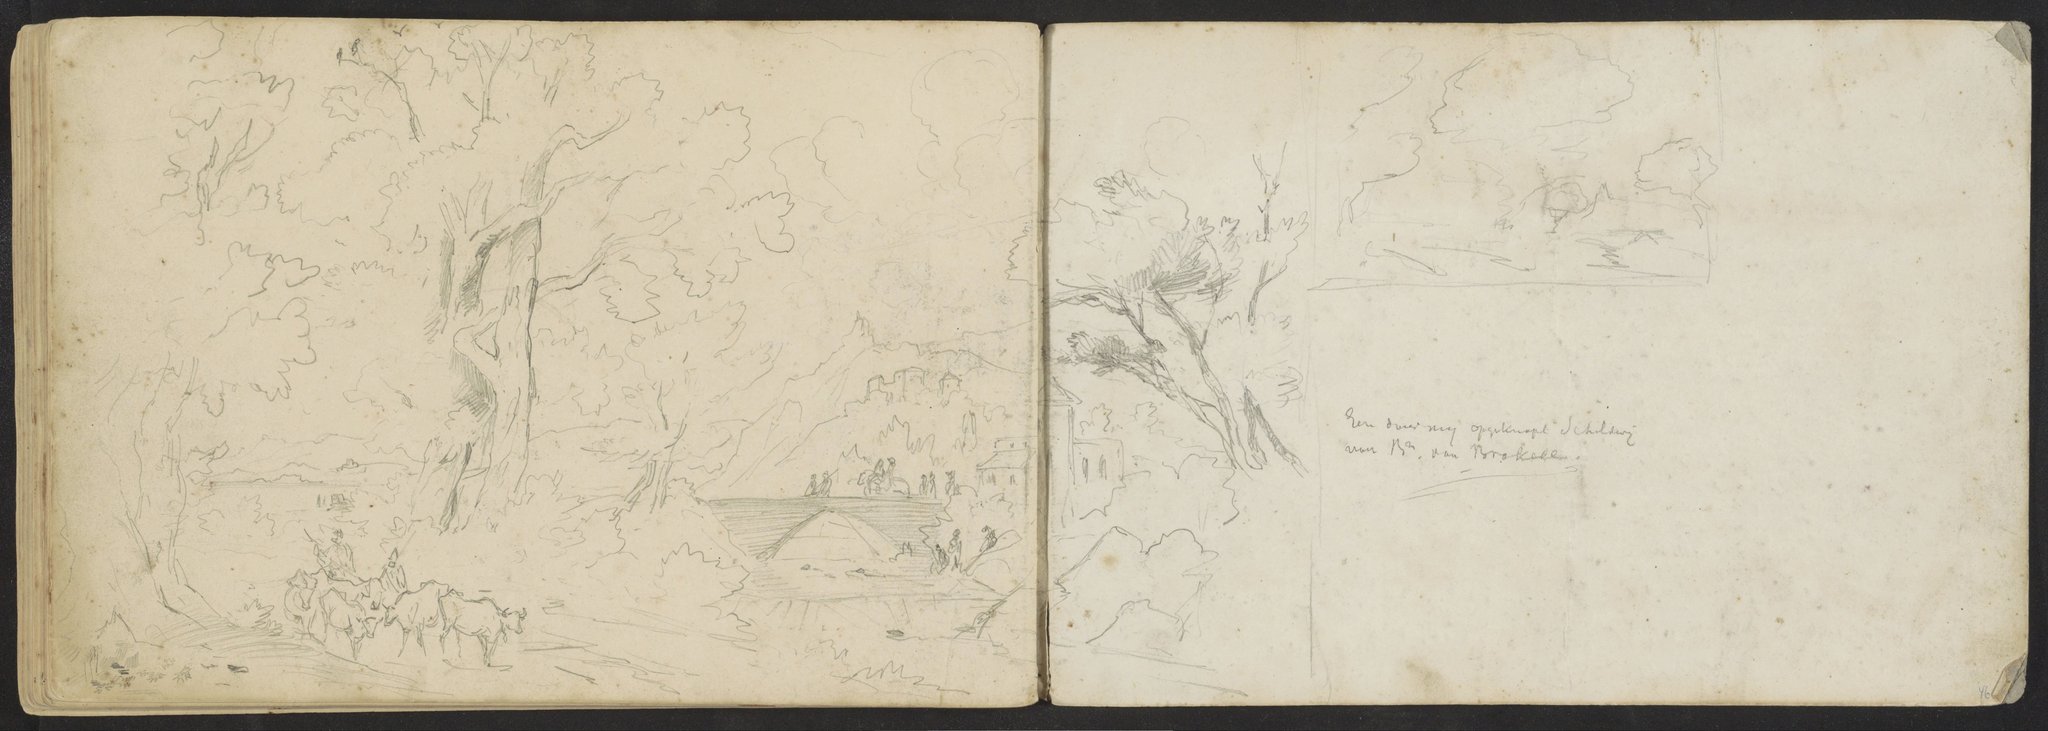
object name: sketchbook leaf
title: Landschap met figuren naar een schilderij van Barend Cornelis Koekkoek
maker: johannes tavenraat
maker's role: draughtsman, painter, print maker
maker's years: 1809-1881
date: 1842-1868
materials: paper, pencil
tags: city-view, and landscape with man-made constructions, road, path, landscapes (+ landscape with figures, staffage)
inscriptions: annotation: ‘Een door mij opgeknapt schilderij/ van Bk, van Brakell.’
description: Blad 45 verso en het achterste schutblad van een schetsboek met 45 bladen.